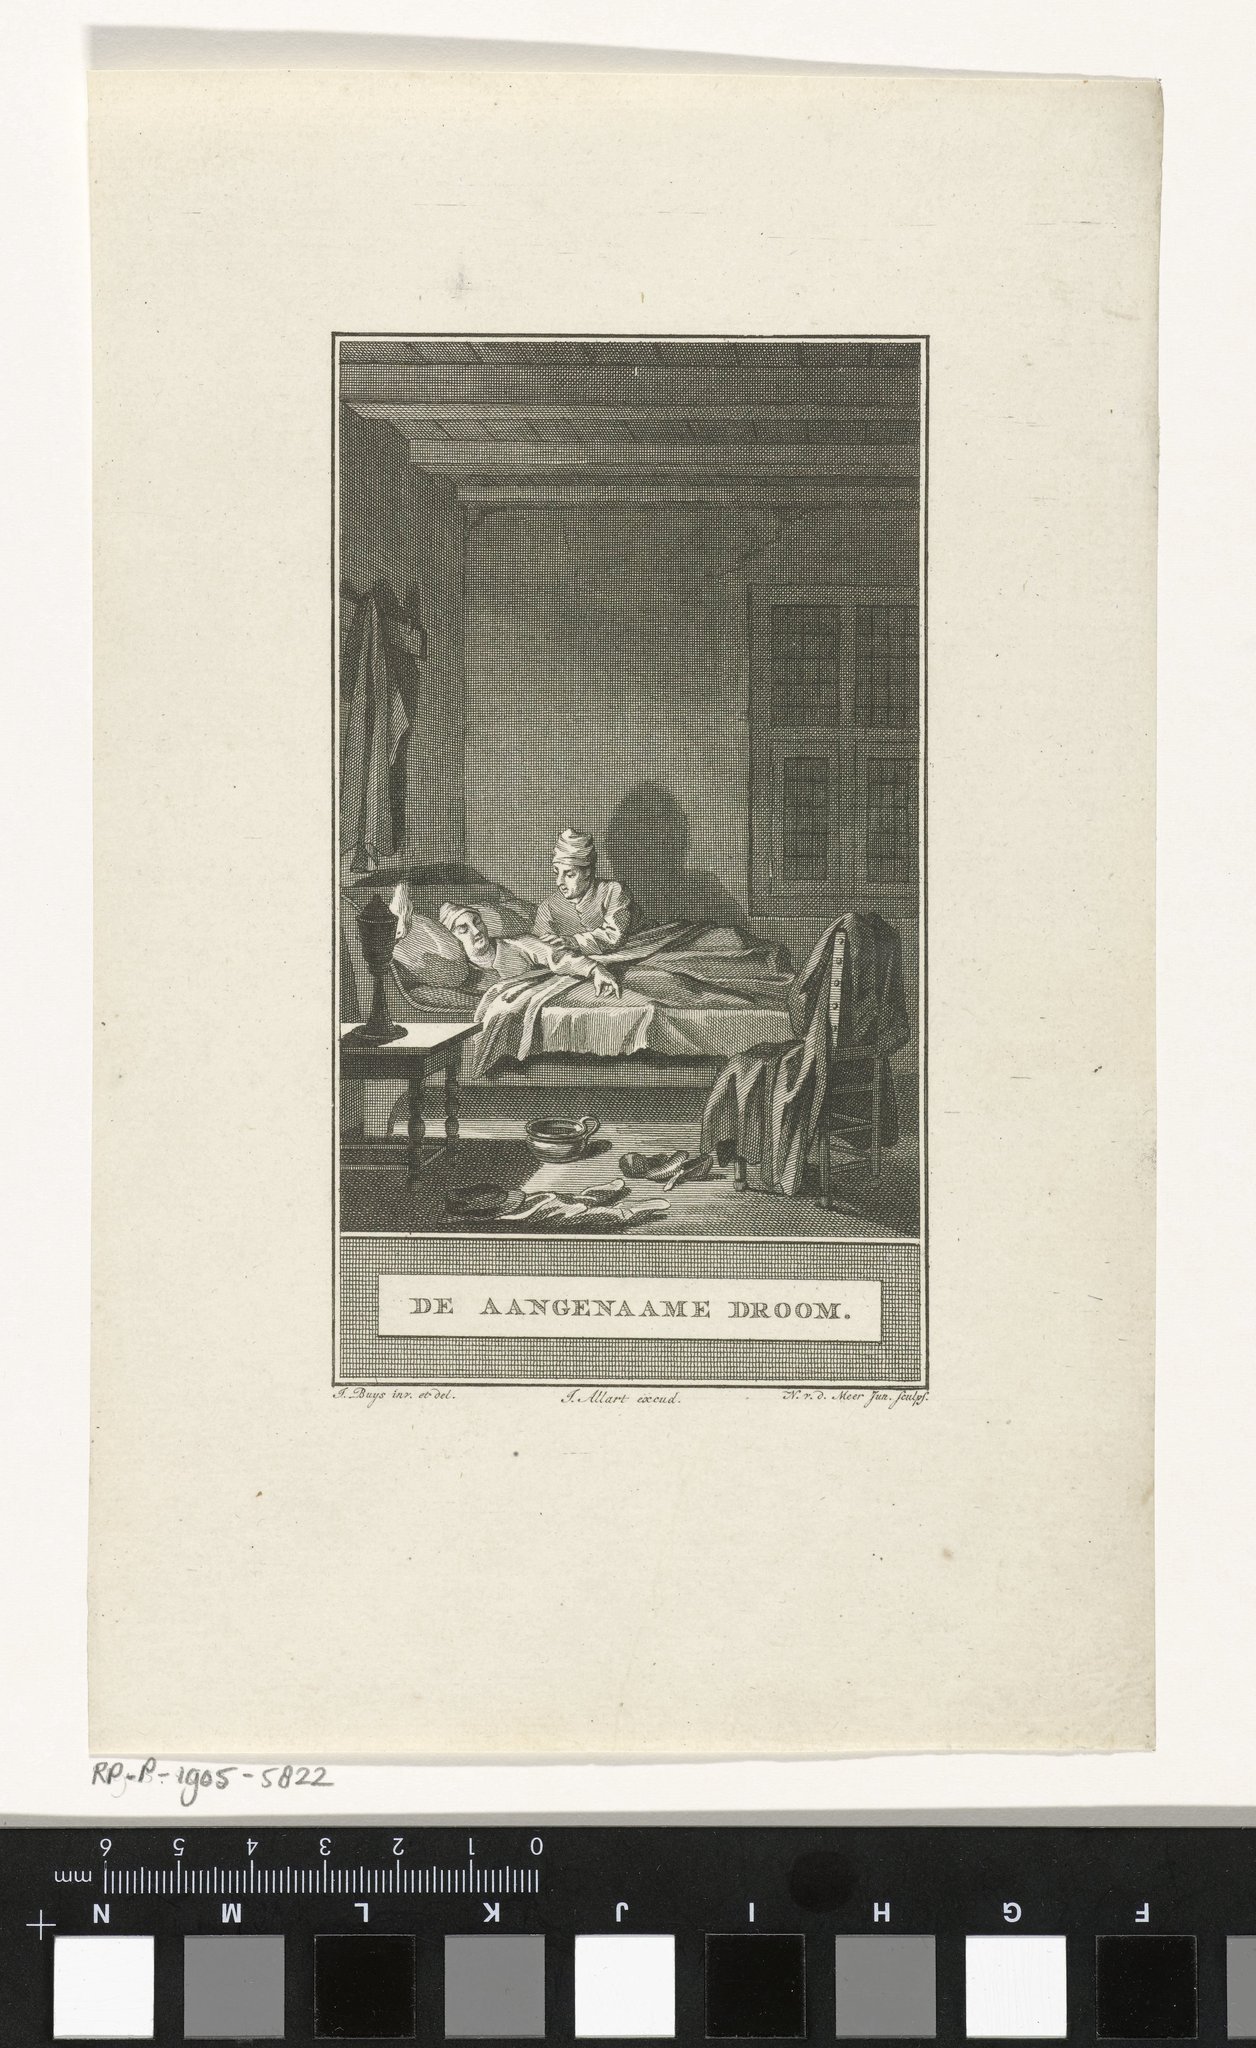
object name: book illustration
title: Ontwaken uit een droom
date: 1778-1785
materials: paper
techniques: etching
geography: amsterdam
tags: waking up, bedroom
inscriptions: collector's mark: Lugt 2228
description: Prent bij: Gellert, Christian Fürchtegott. Fabelen en vertelsels. 3 dln. Amsterdam: Pieter Meyer, 1772-1774. De prenten bij deze publicatie werden later uitgegeven. De exemplaren uitgegeven door de weduwe Jacobus Loveringh & Johannes Allart tussen 1777 en 1778, de exemplaren uitgegeven door alleen Johannes Allart tussen 1778 en 1785.